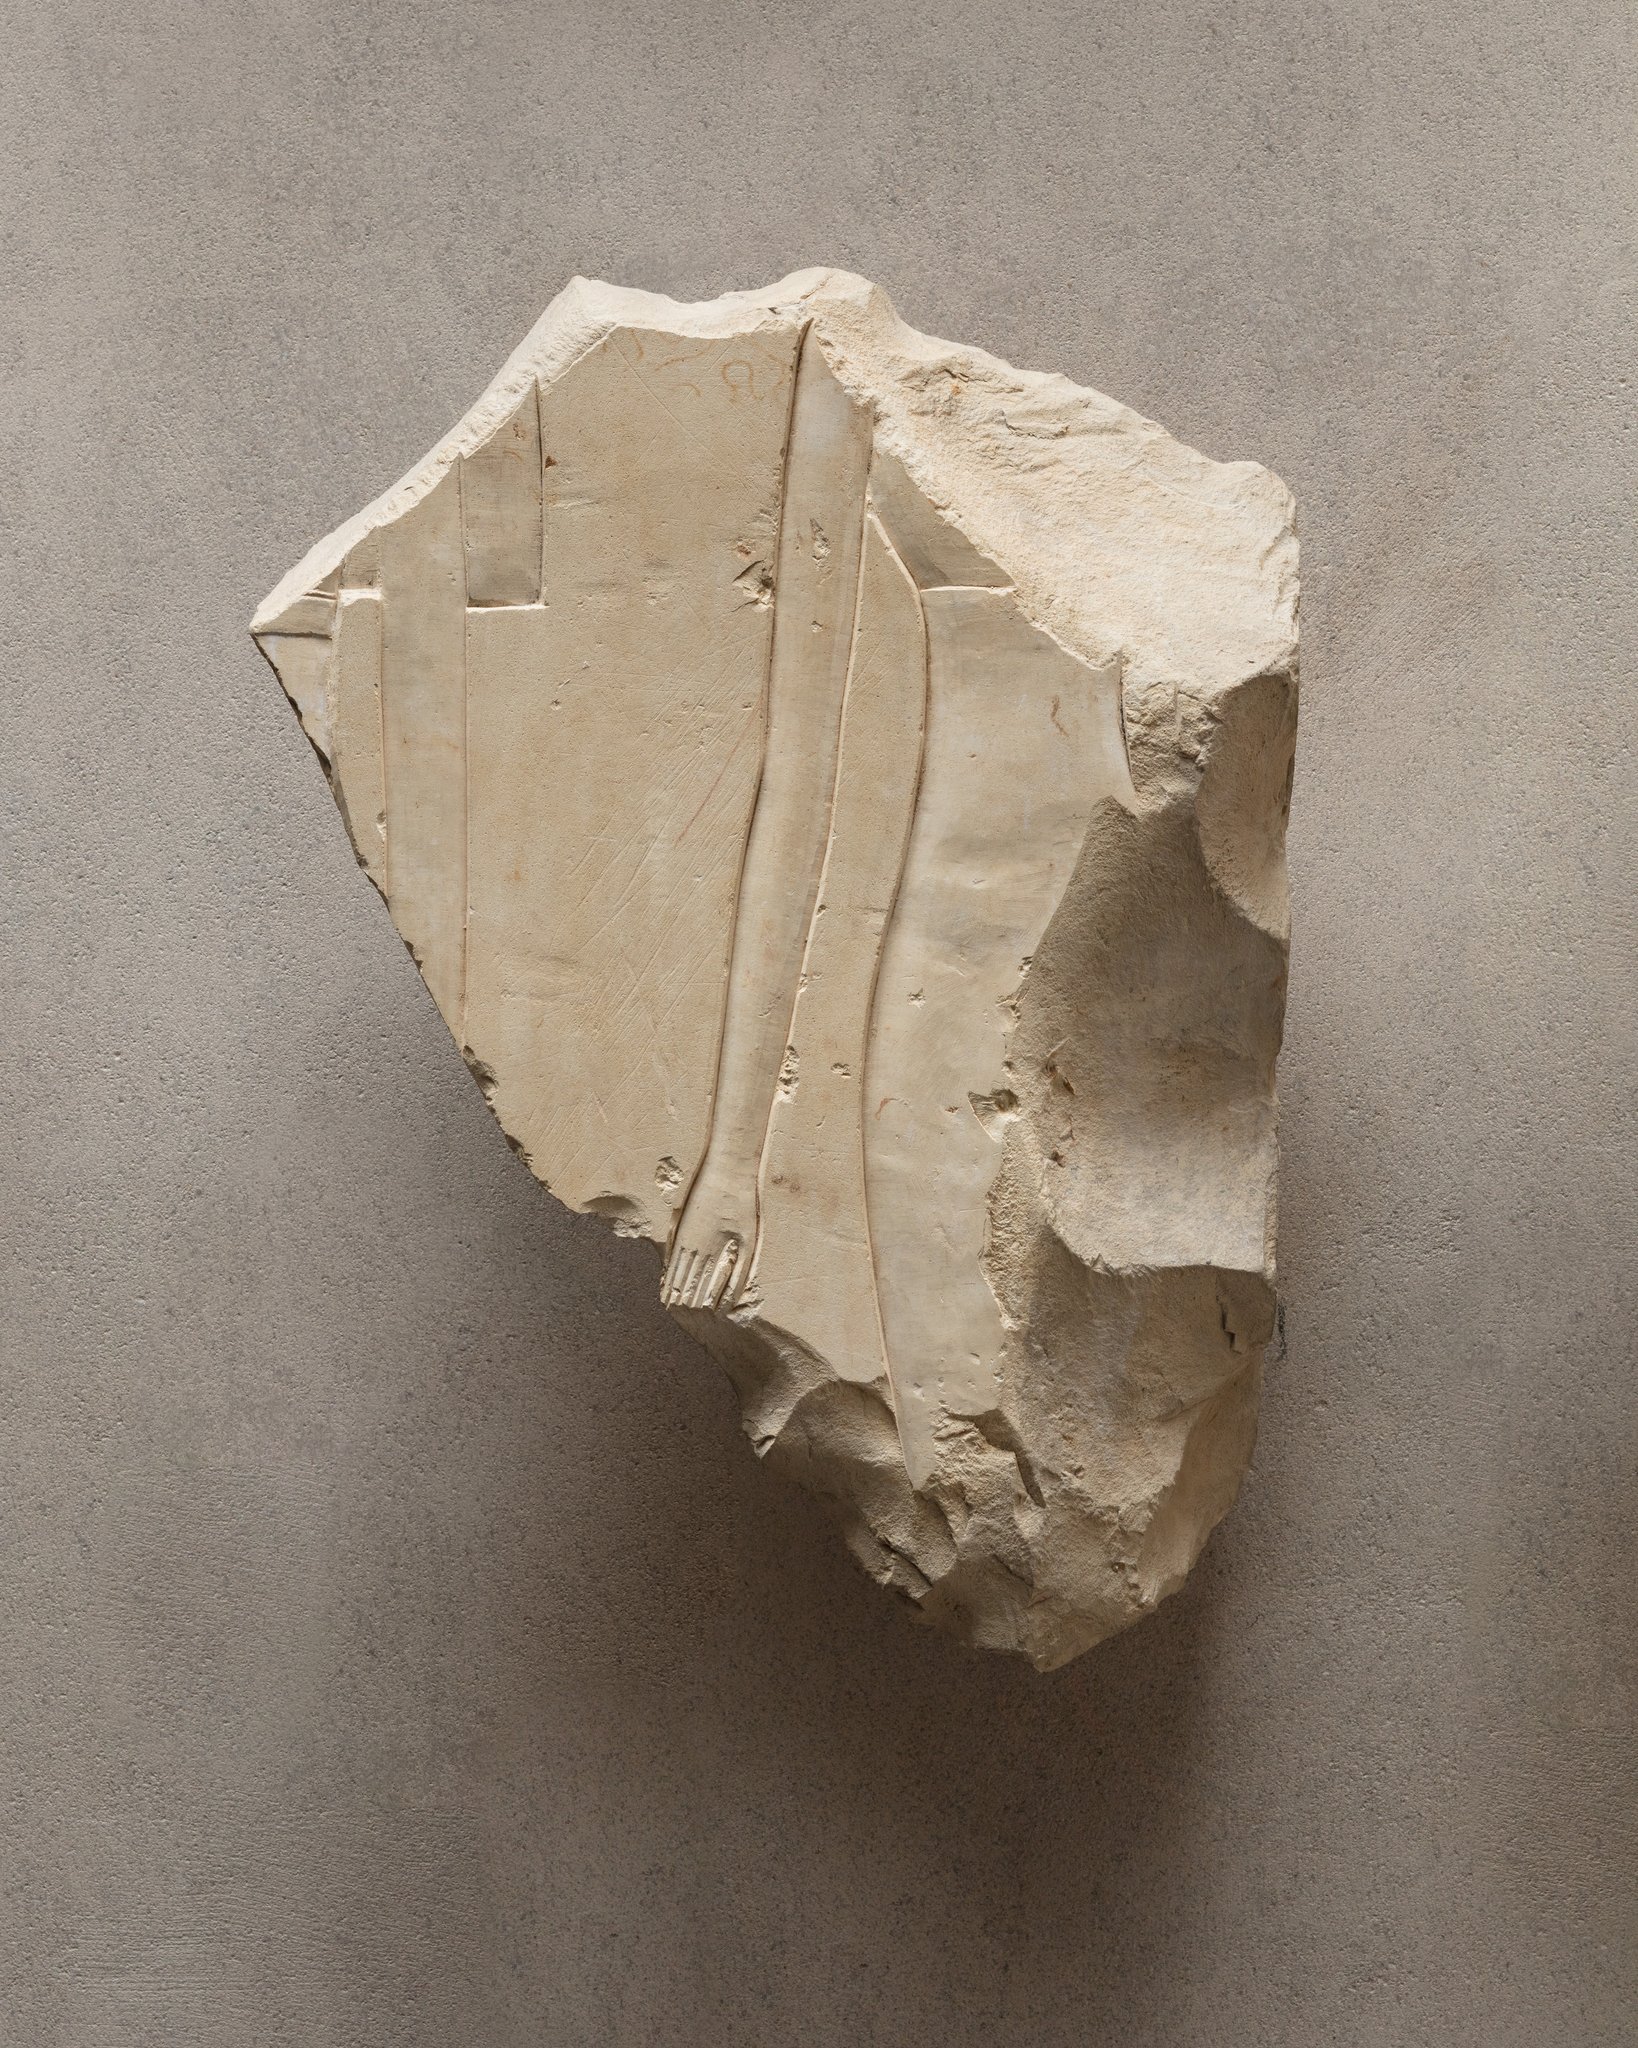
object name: relief fragment, tomb of neferu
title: Relief fragment from a procession of attendants - see 31.3.1-1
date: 2051-2030 BCE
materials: limestone, paint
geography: egypt